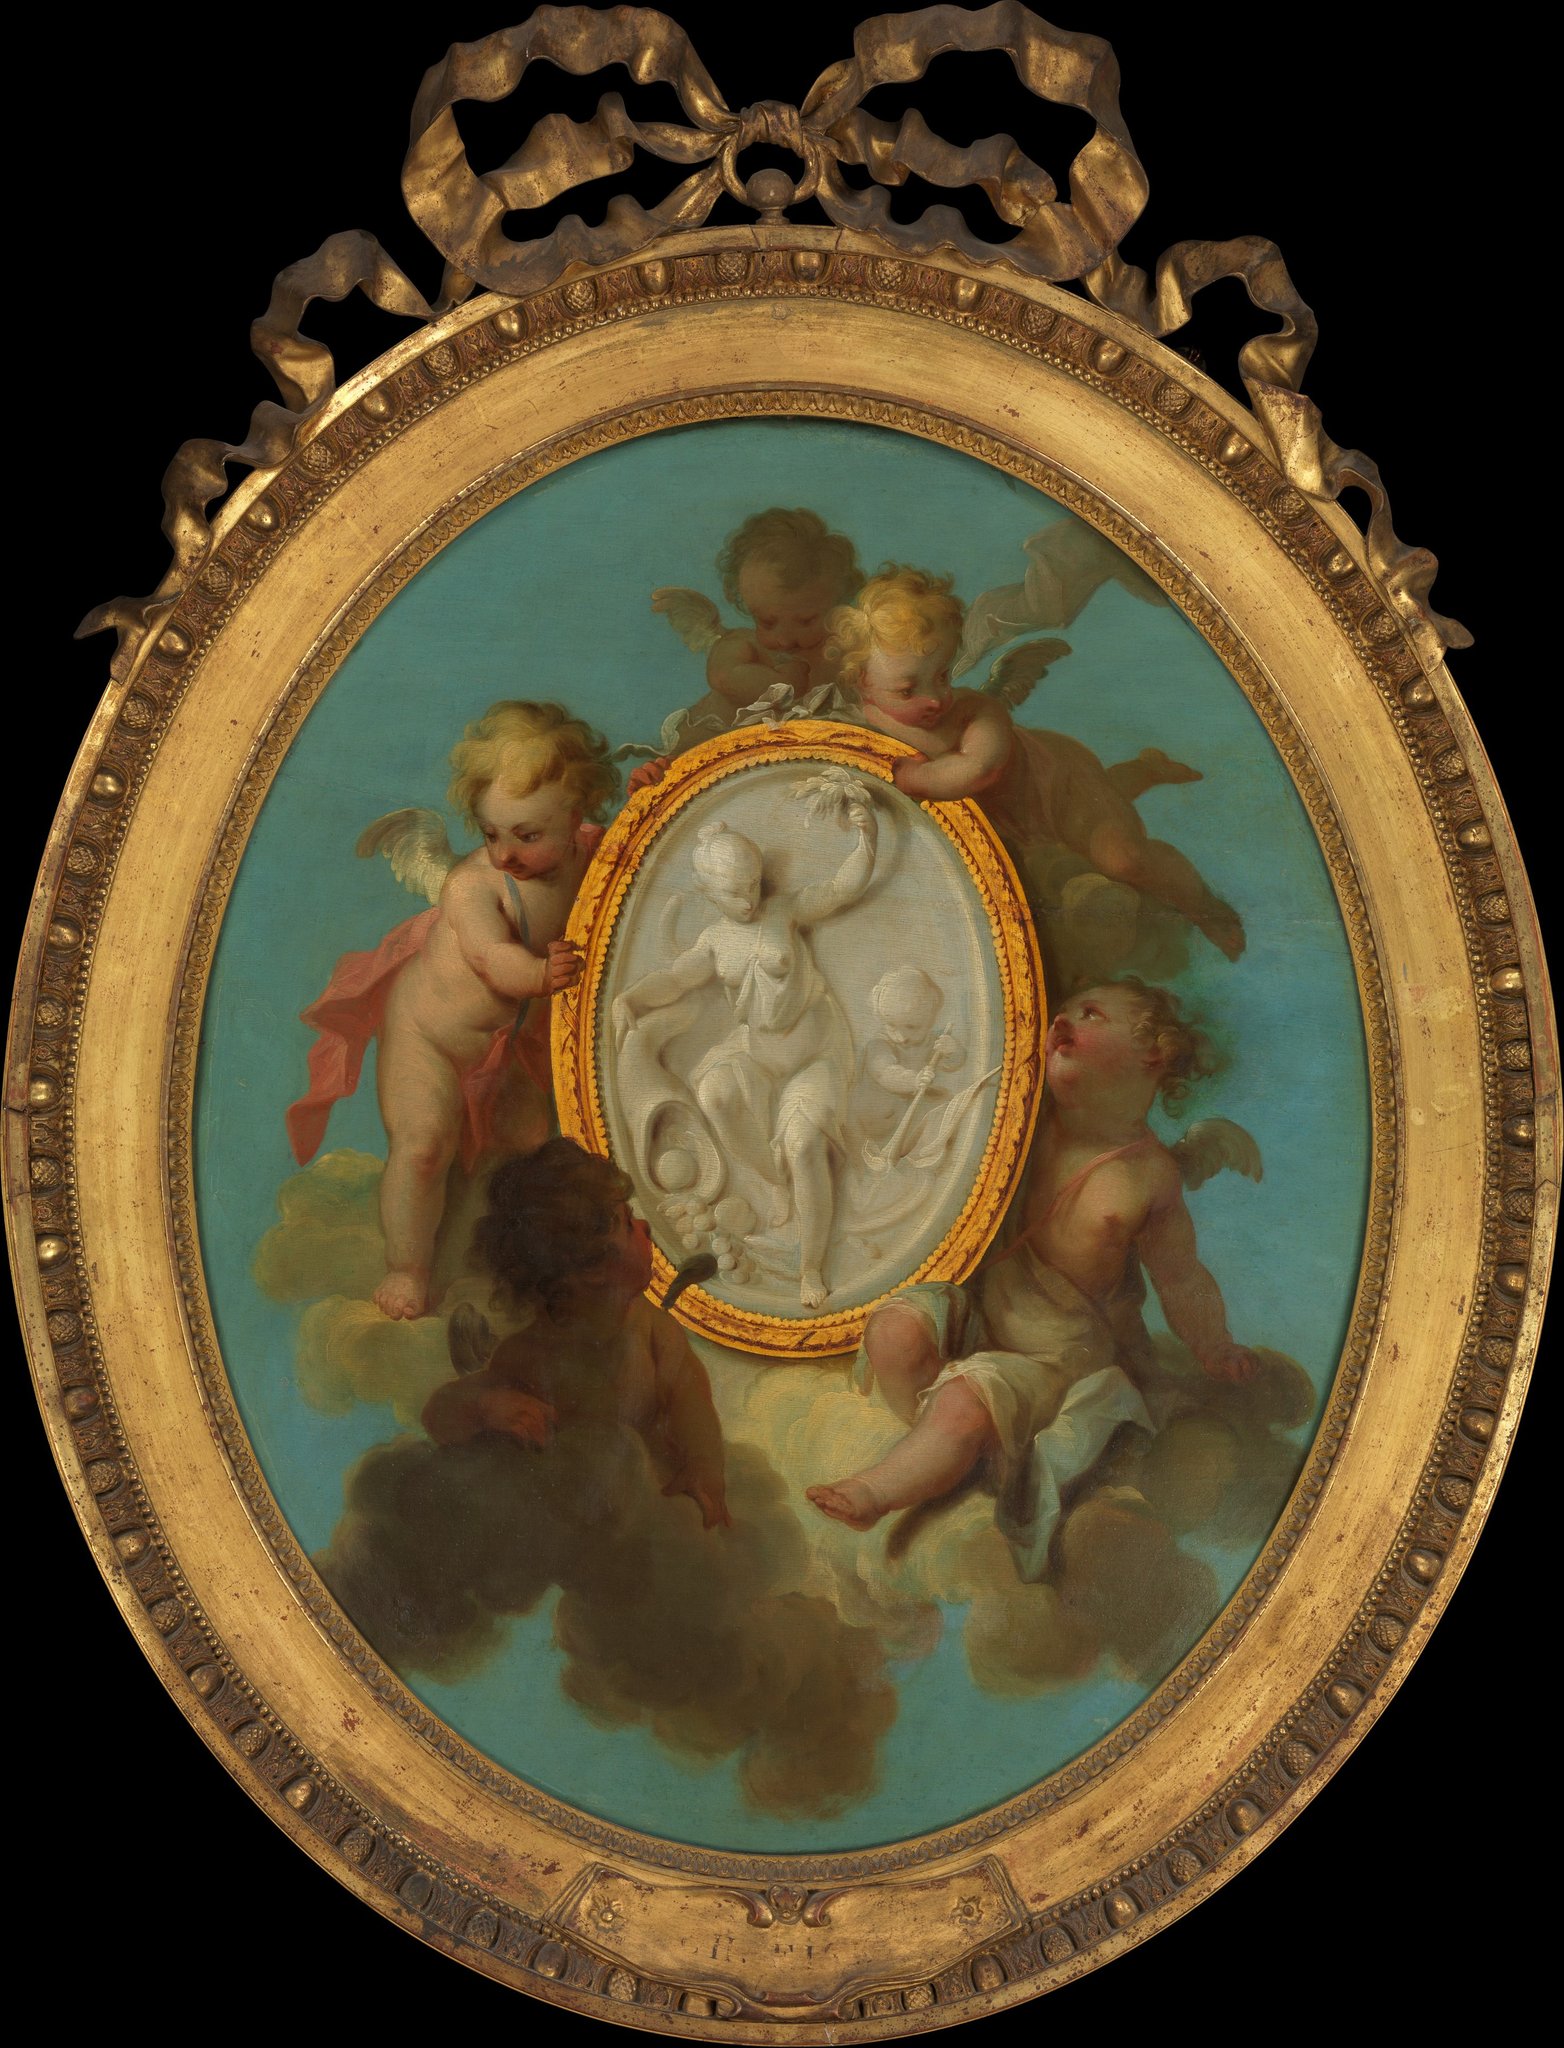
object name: painting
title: Putti with a Medallion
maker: charles dominique joseph eisen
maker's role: artist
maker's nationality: french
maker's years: 1720-1778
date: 1740-1778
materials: oil, wood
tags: medallions,putti